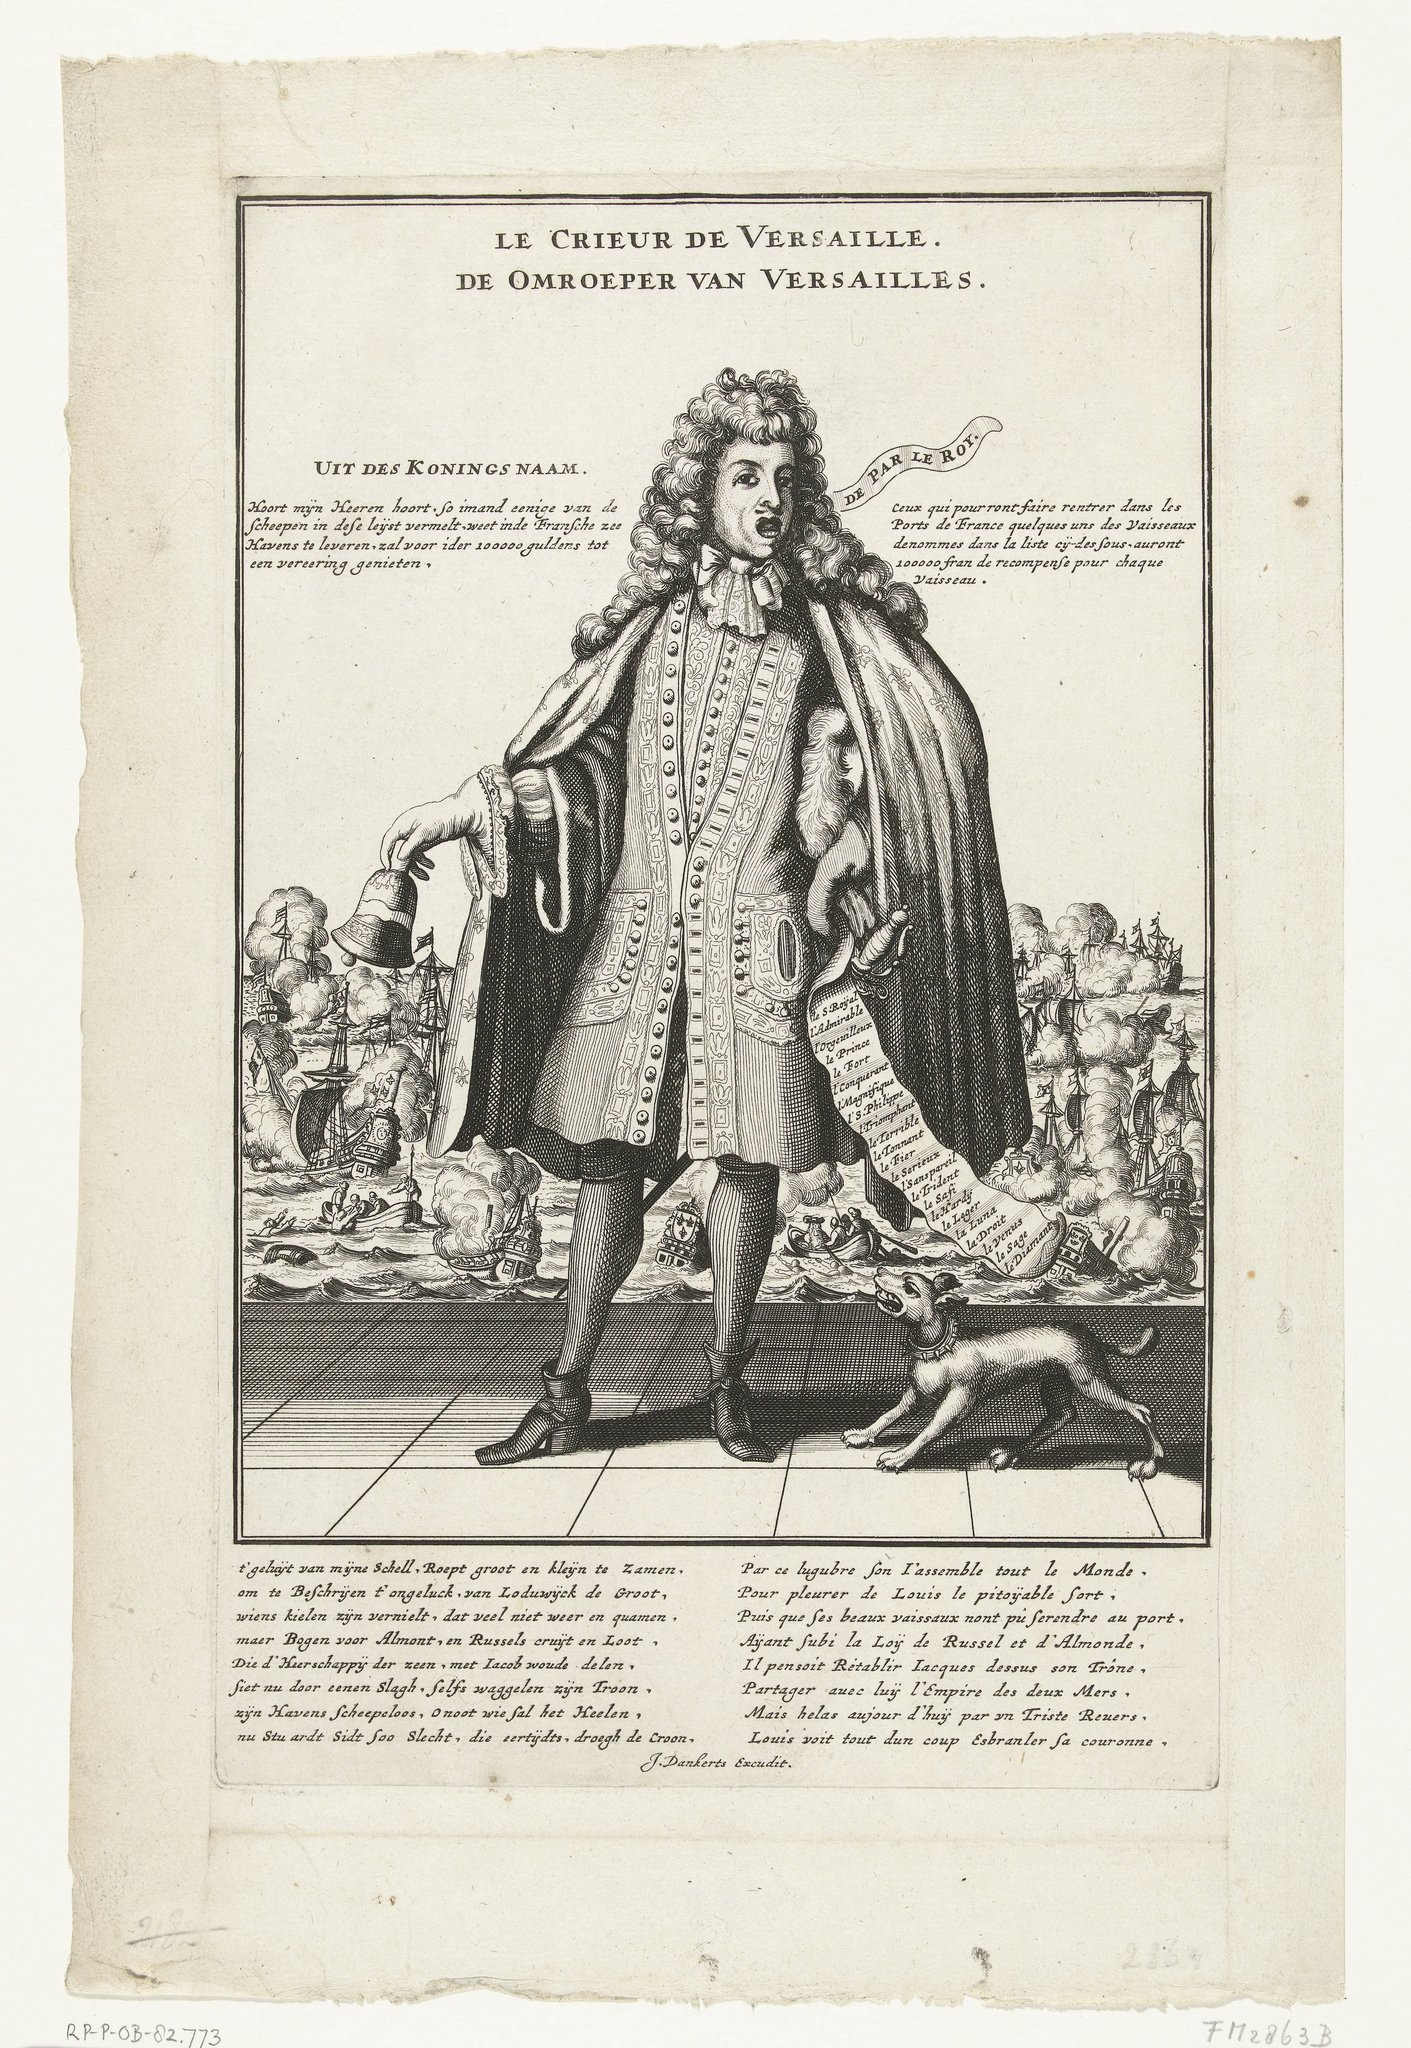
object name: cartoon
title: Le Crieur de Versaille / De Omroeper van Versailles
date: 1692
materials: paper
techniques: engraving, etching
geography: northern netherlands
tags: lodewijk xiv (koning van frankrijk), paris, battle (+ naval force), oral spreading of news, town crier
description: De Omroeper van Versailles. Spotprent op de Franse koning Lodewijk XIV die als een stadsomroeper het nieuws brengt van de nederlaag in de zeeslag bij Kaap la Hogue waarbij de Fransen onder admiraal de Tourville werden verslagen door de gecombineerde vloot van Engeland en Holland onder de admiralen Russel en Almonde, 29 mei t/m 3 juni 1692. In de rechterhand een schel, in de linkerhand een lange lijst met de namen van de verbrande Franse schepen, bij zijn voeten een blaffend hondje, op de achtergrond de zeeslag. In de voorstelling een oproep uit naam van de koning in het Nederlands en Frans, onderaan twee verzen van acht regels in het Nederlands en Frans.